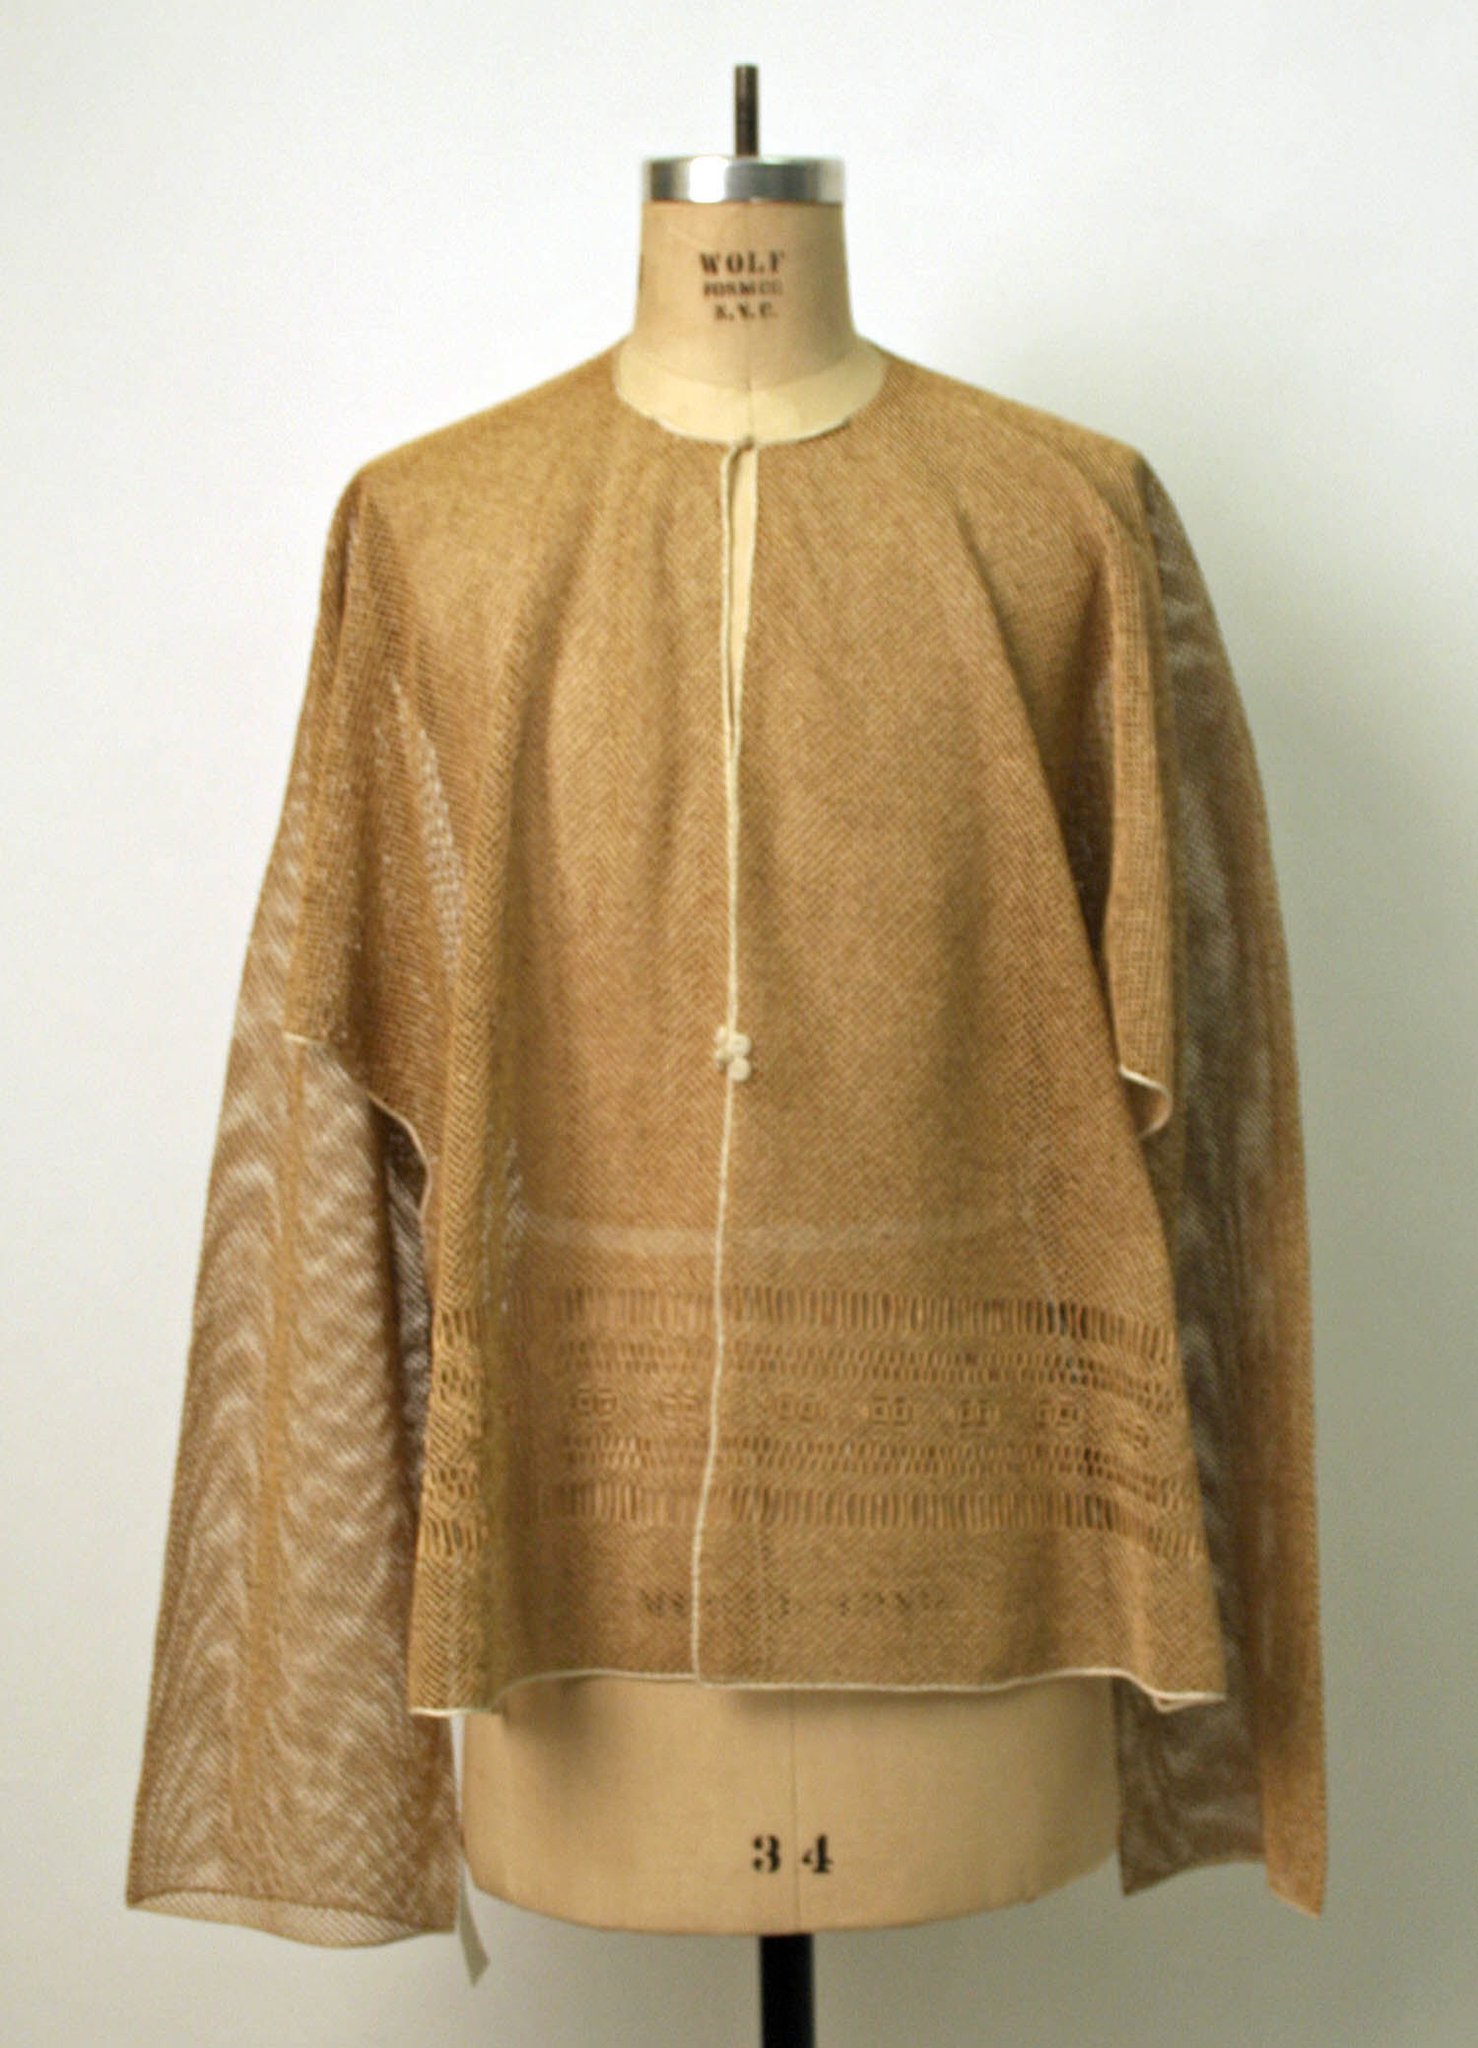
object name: underwear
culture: chinese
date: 1801-1900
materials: bamboo, cotton